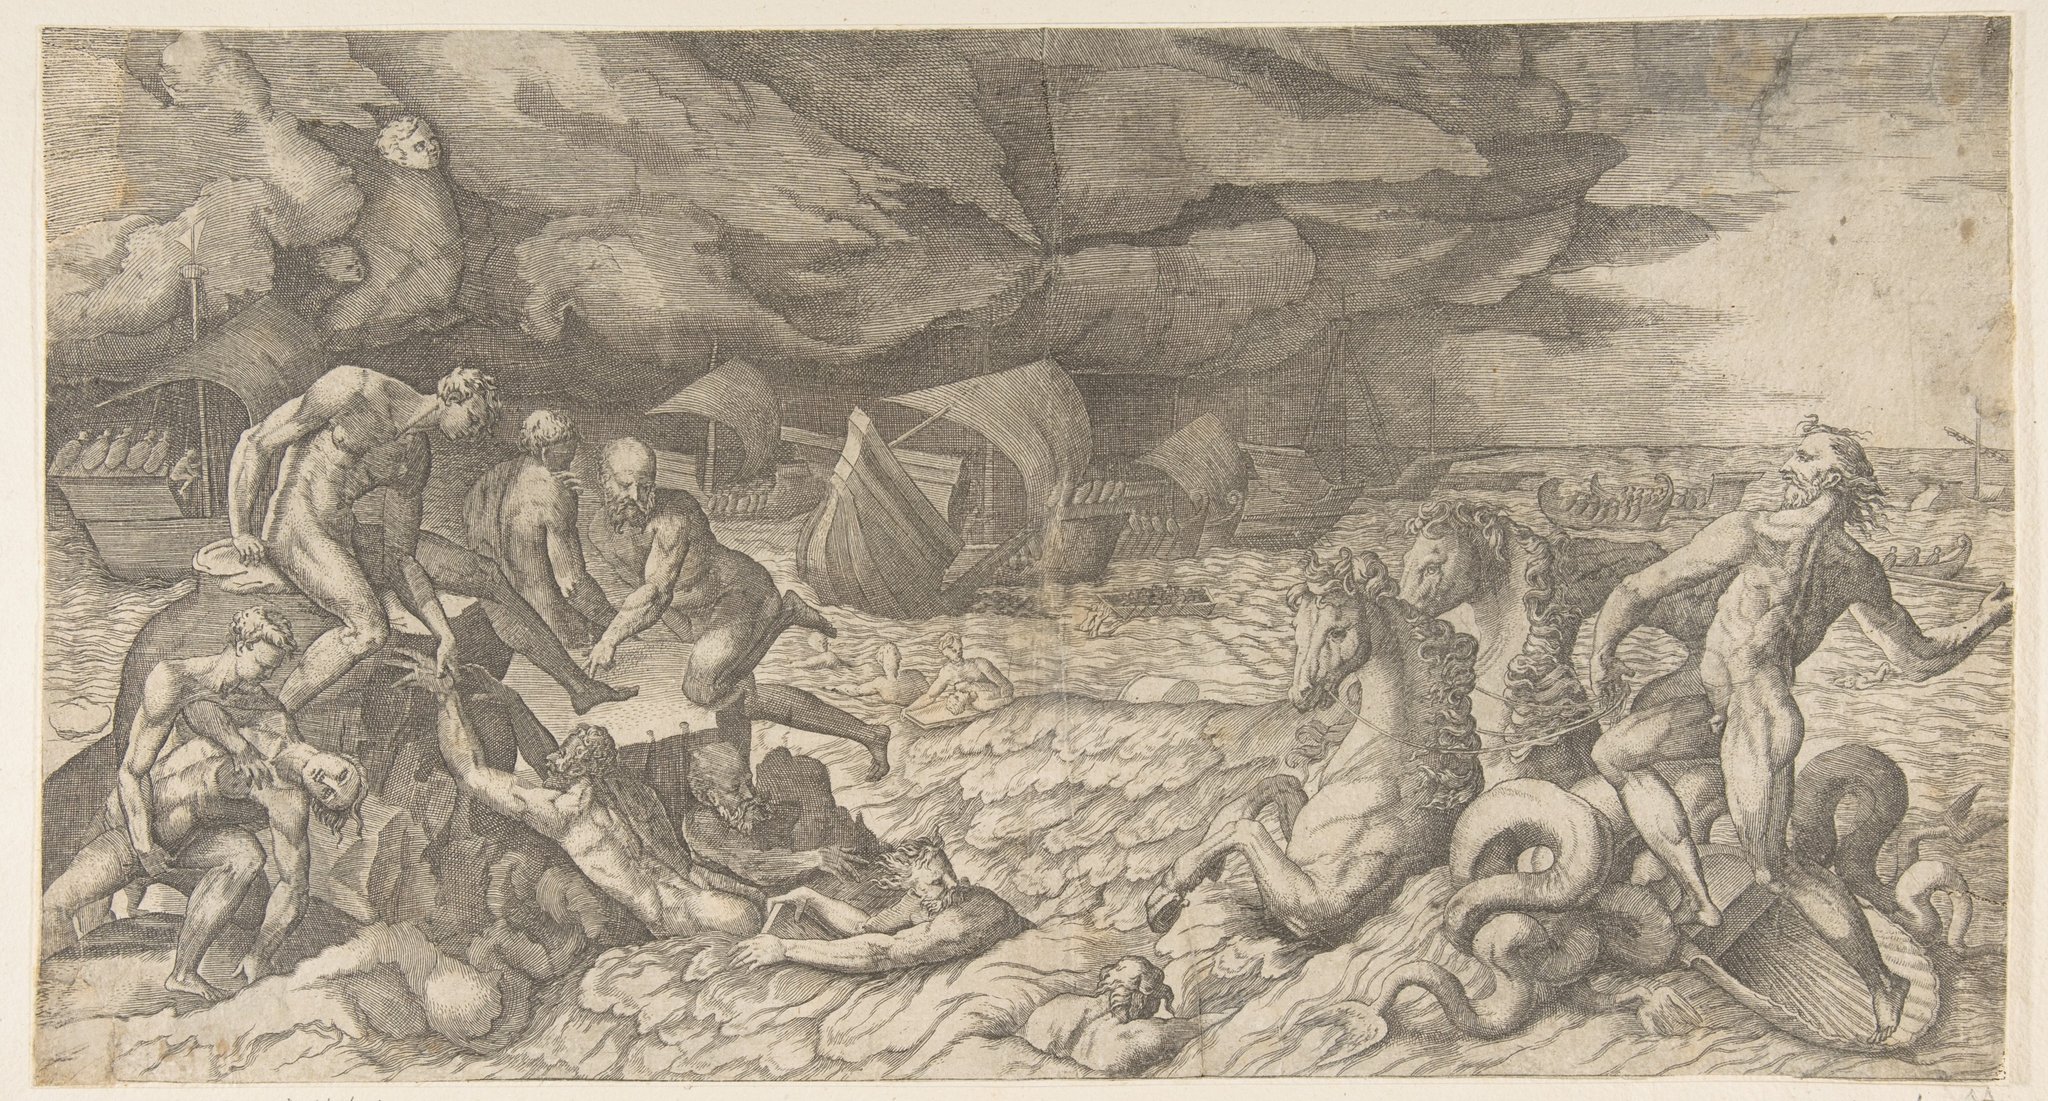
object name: print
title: Neptune calming the Tempest Aeolus raised against the Fleet of Aeneas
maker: giulio bonasone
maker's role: artist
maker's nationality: italian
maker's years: 1510-1576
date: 1531-1576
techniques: engraving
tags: aeneas,neptune,boats